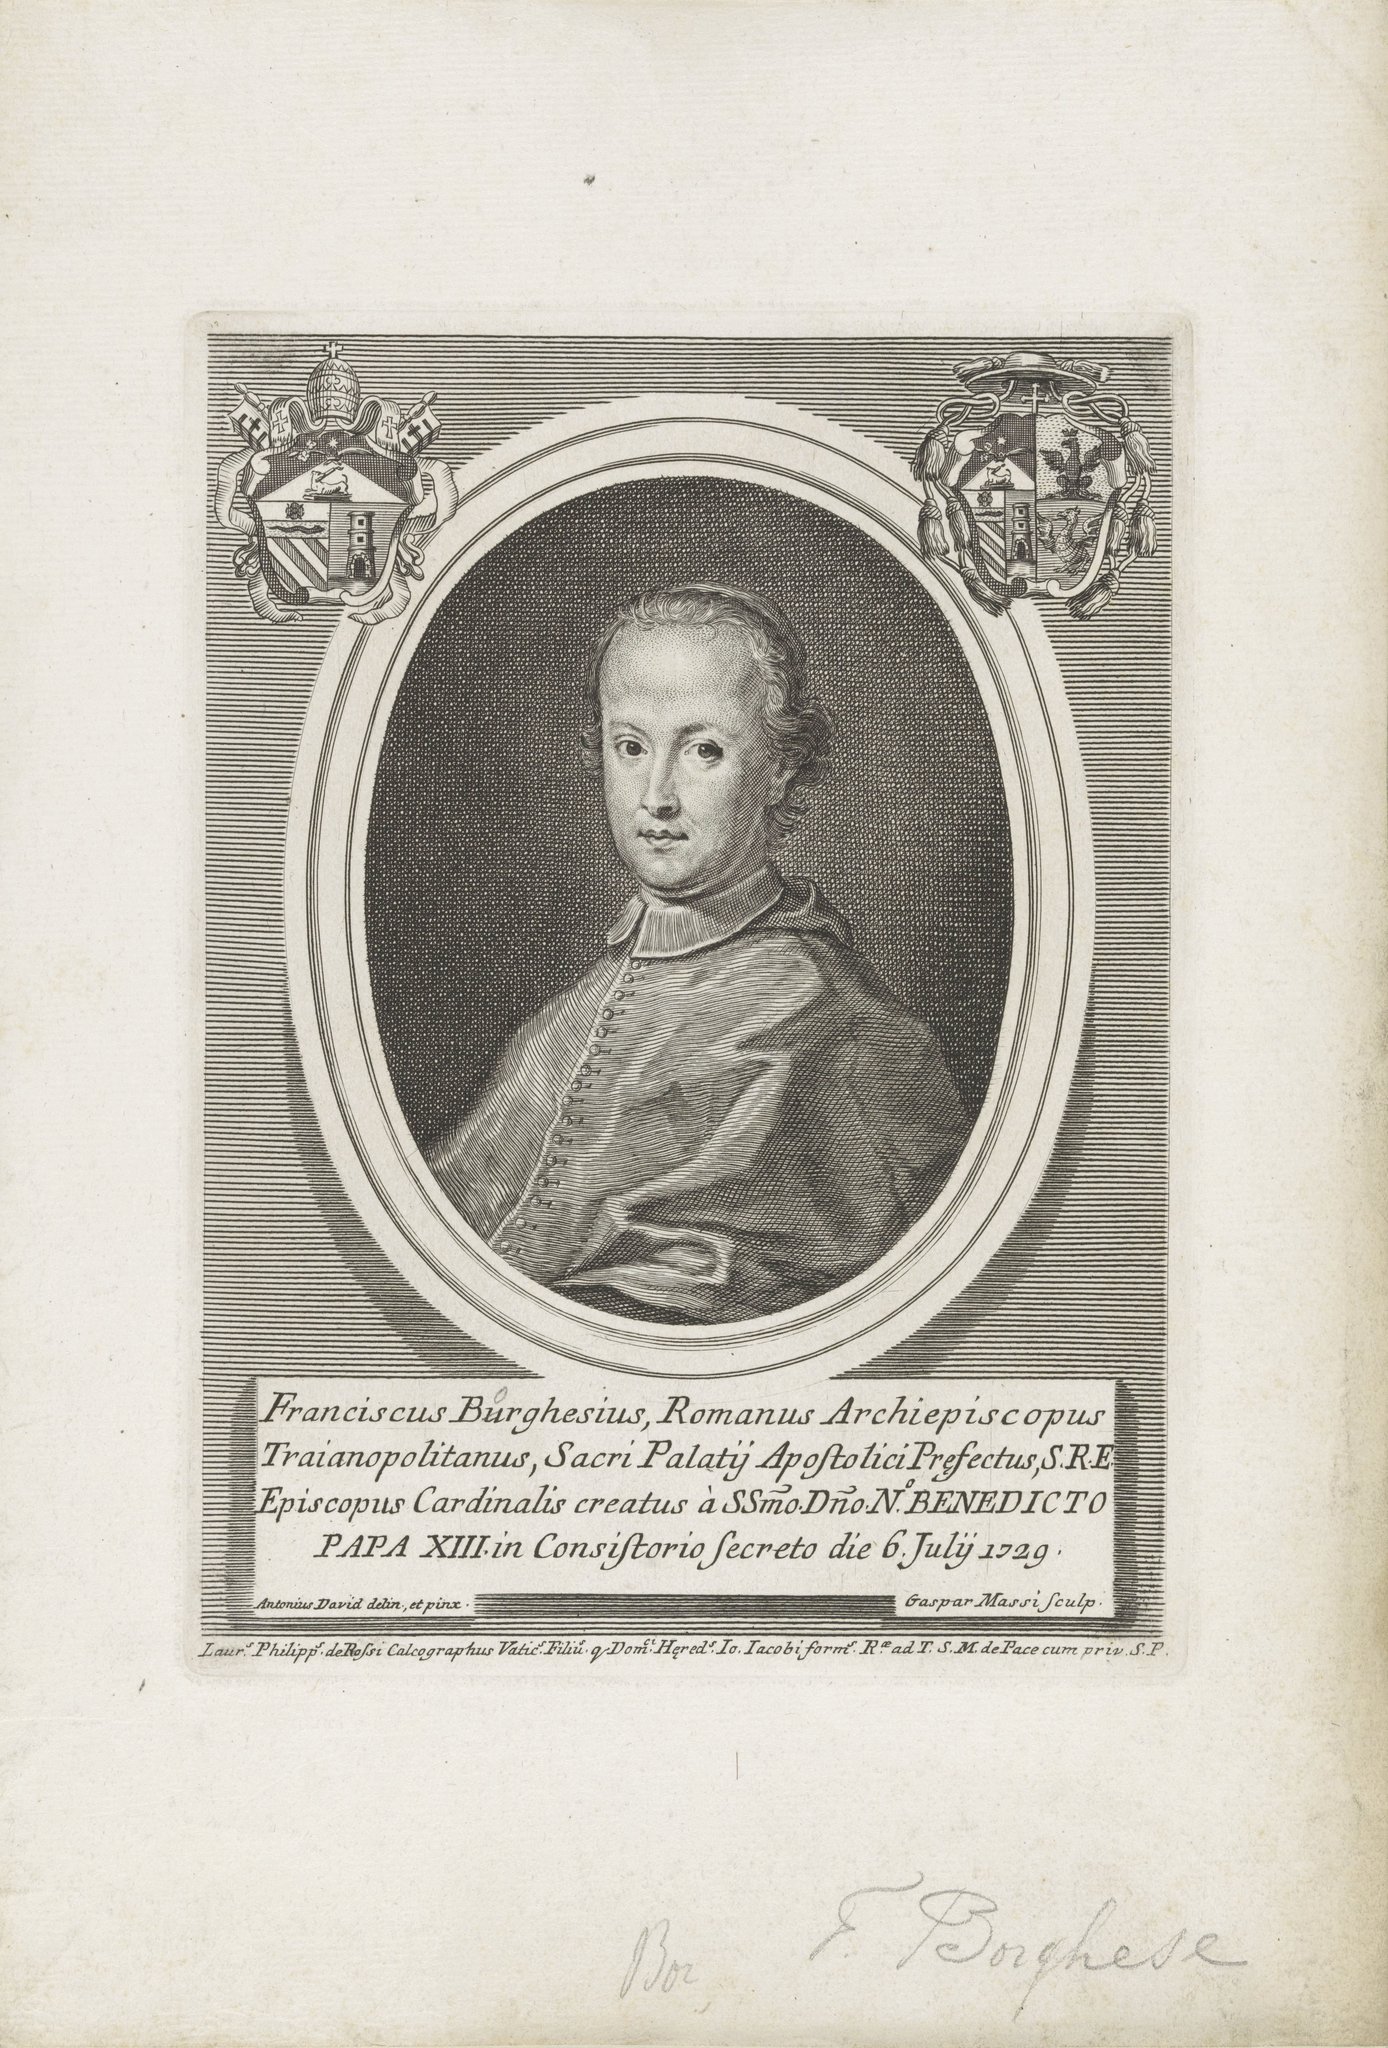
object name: print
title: Effigies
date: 1729-1731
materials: paper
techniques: engraving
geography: vatican city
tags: rome, cardinal, historical persons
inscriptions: collector's mark: Lugt 2228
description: Prent uit een reeks van onbekende omvang met portretten van kardinalen. De prenten werden vanaf 1657 vervaardigd in opdracht van uitgever Giovanni Giacomo de’ Rossi, waarna de productie werd voortgezet onder leiding van zijn opvolgers Domenico de’ Rossi en Lorenzo Filippo de’ Rossi, en tenslotte onder leiding van de Calcographia R.C.A.